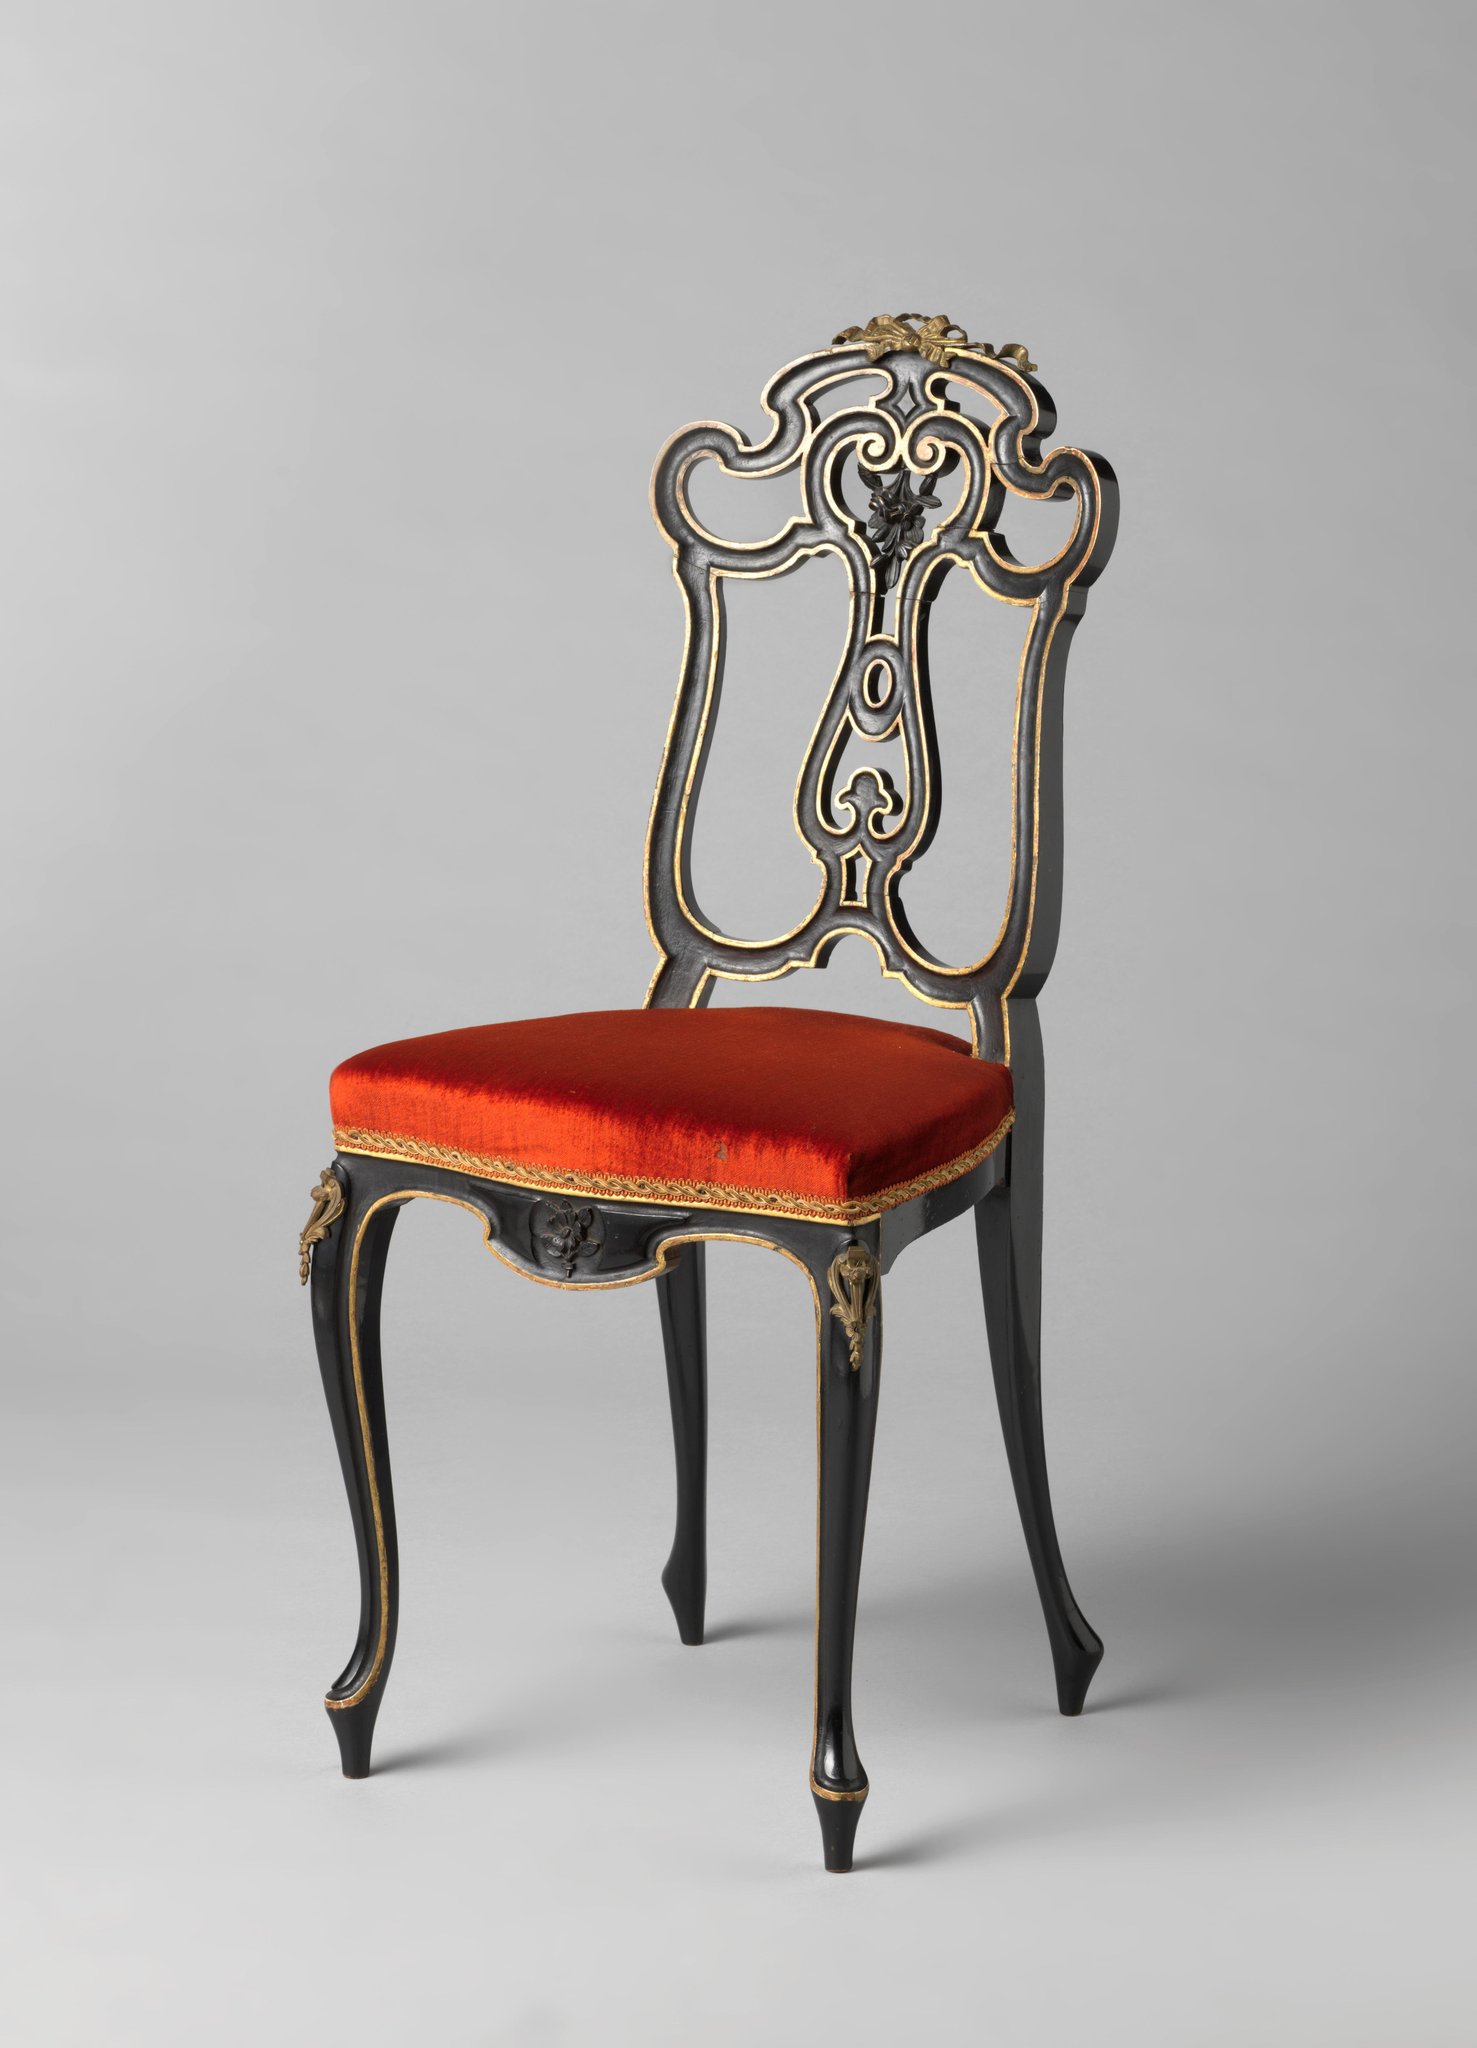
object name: furniture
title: Stoel, afwisselend glanzend en dof zwart geschilderd en versierd met vergulde randen en enkele goudkleurige beslagstukjes. Bekleed met oranje velours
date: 1865-1875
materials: pigment, brass, textile, wood, wool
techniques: gilding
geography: the hague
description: Chair. Wood painted black and gold. The Hague, c. 1870, by the Horrix Brothers.